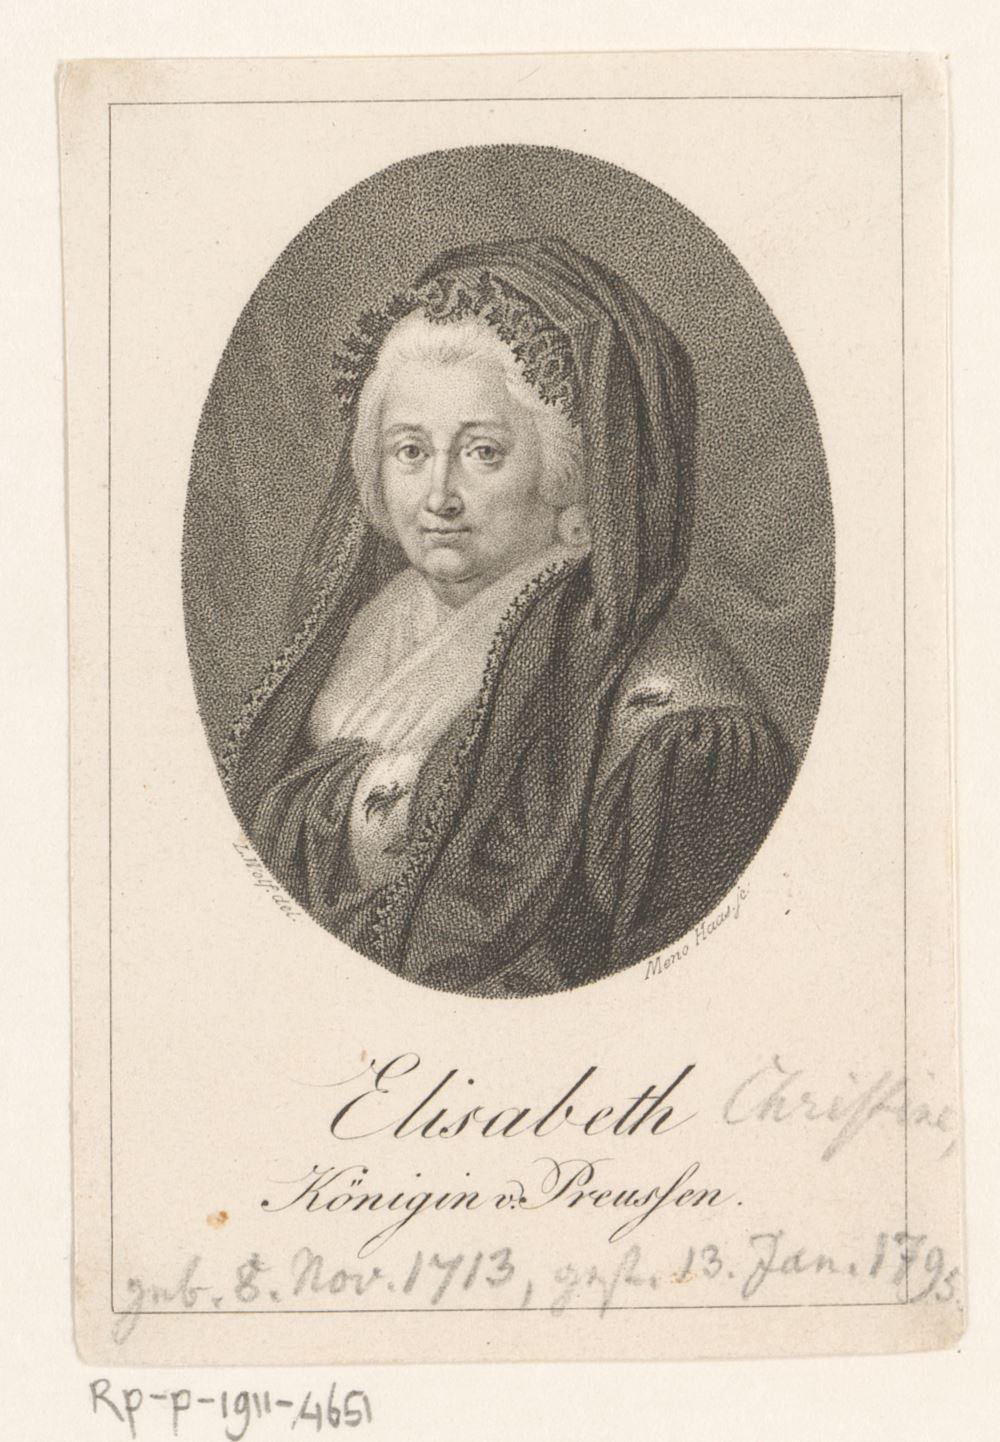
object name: print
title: Portret van Elisabeth Christine van Brunswijk-Bevern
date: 1786-1833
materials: paper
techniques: engraving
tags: historical persons - bb - woman, ruler, sovereign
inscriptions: collector's mark: Lugt 2228